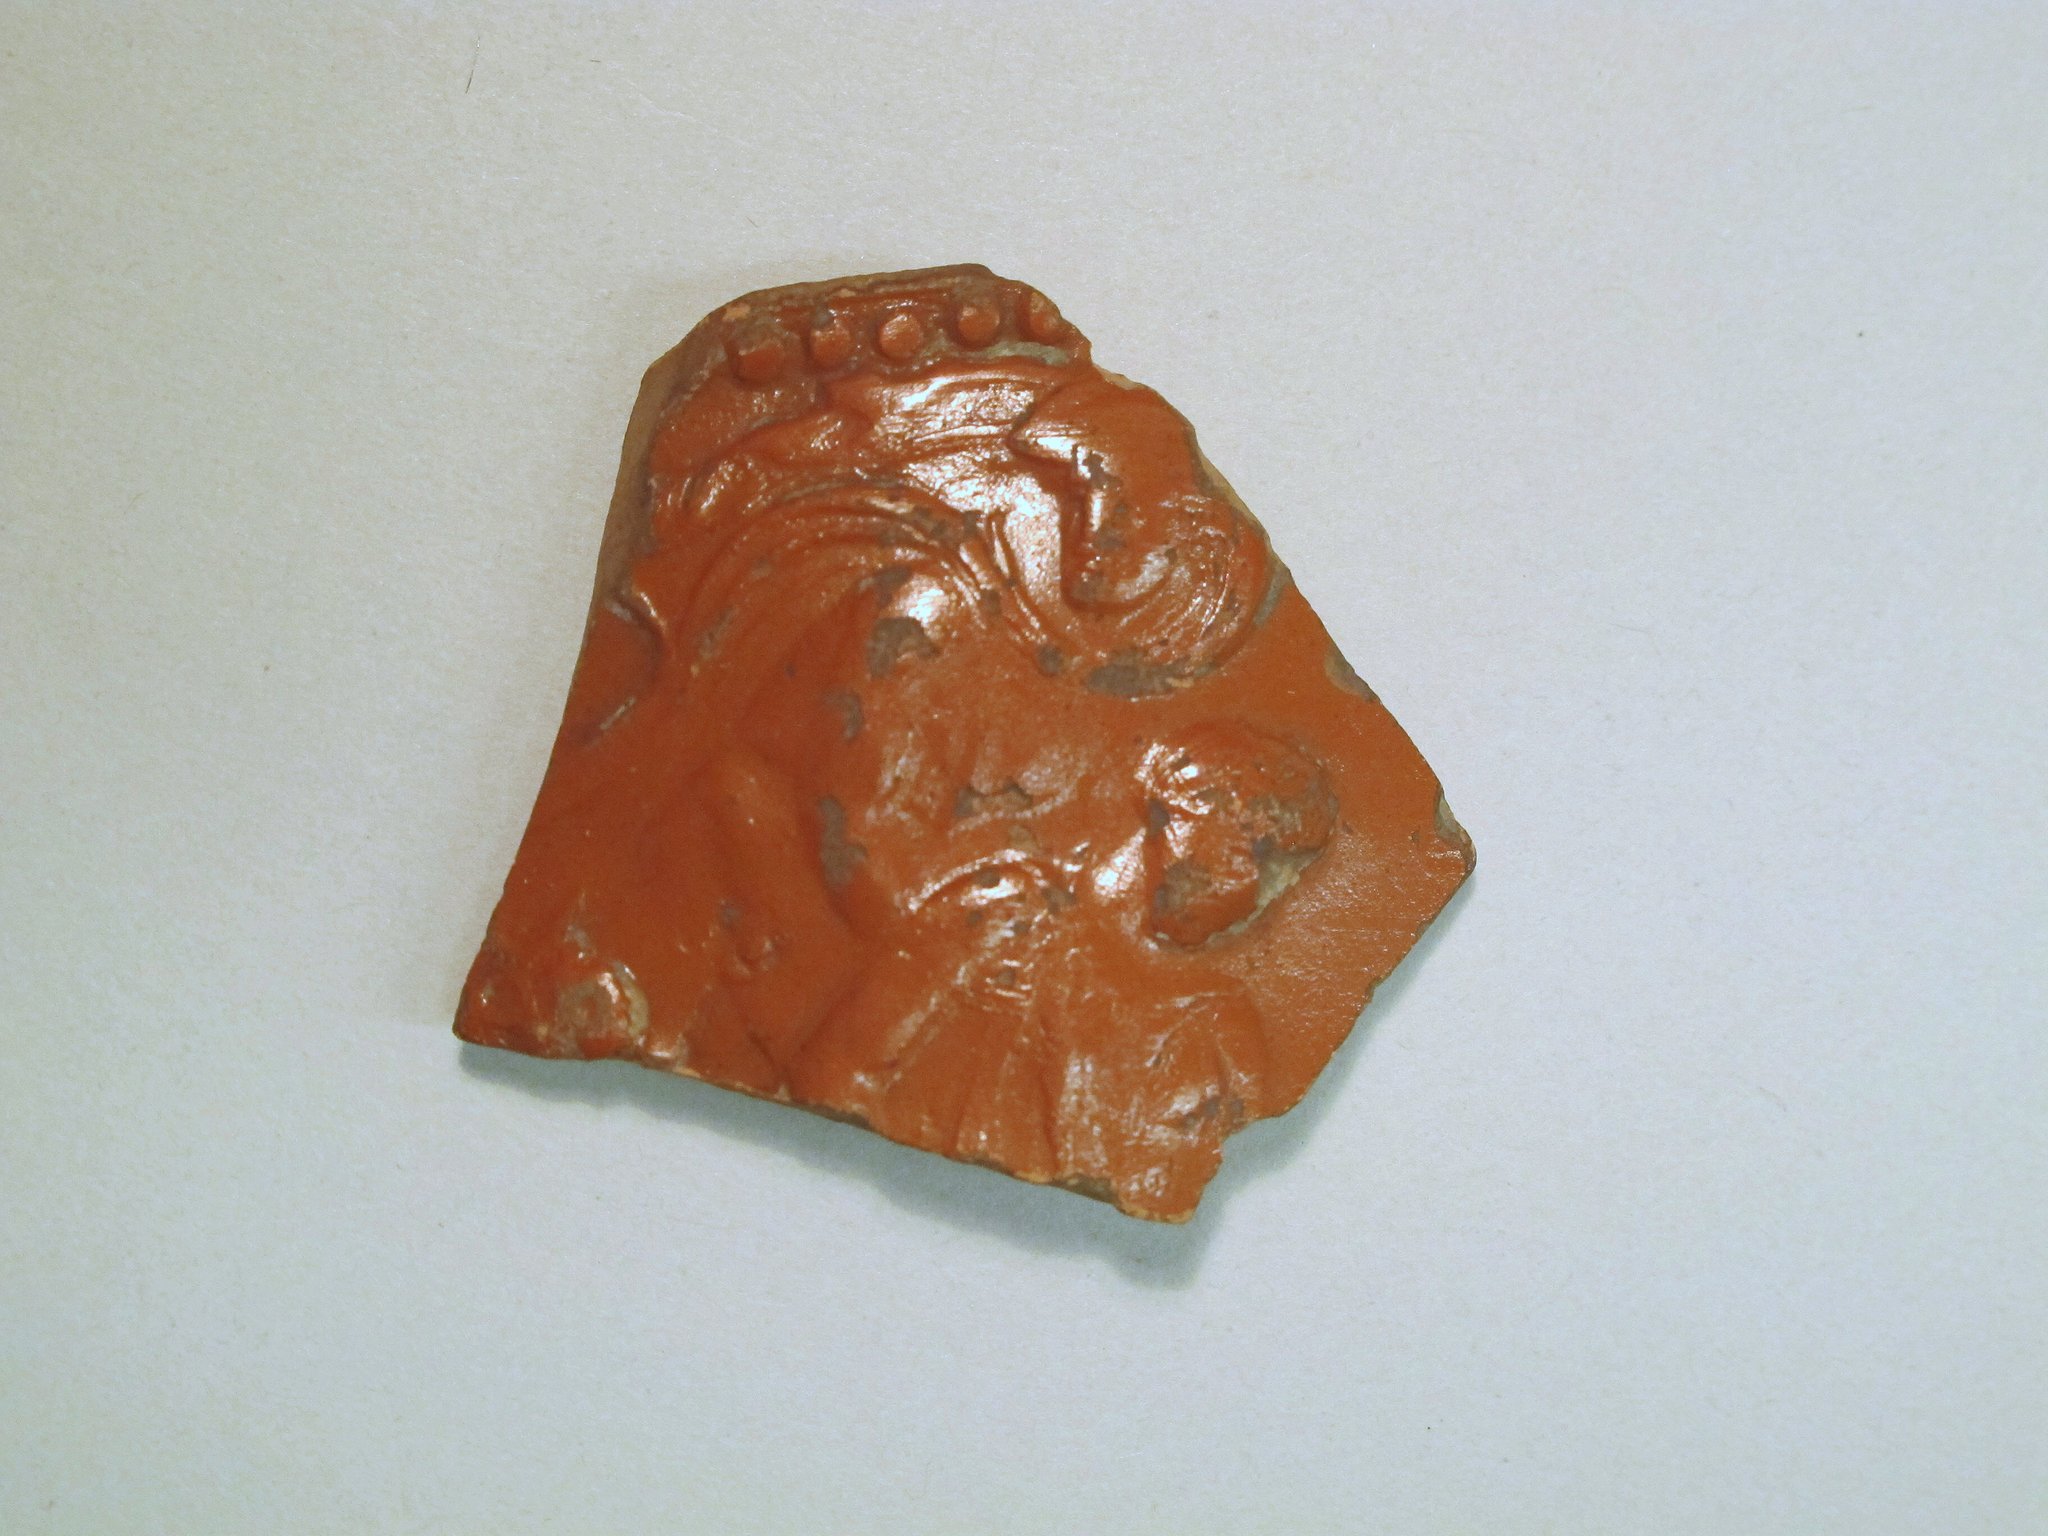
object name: vase fragment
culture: roman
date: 100 BCE-100 CE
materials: terracotta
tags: human figures